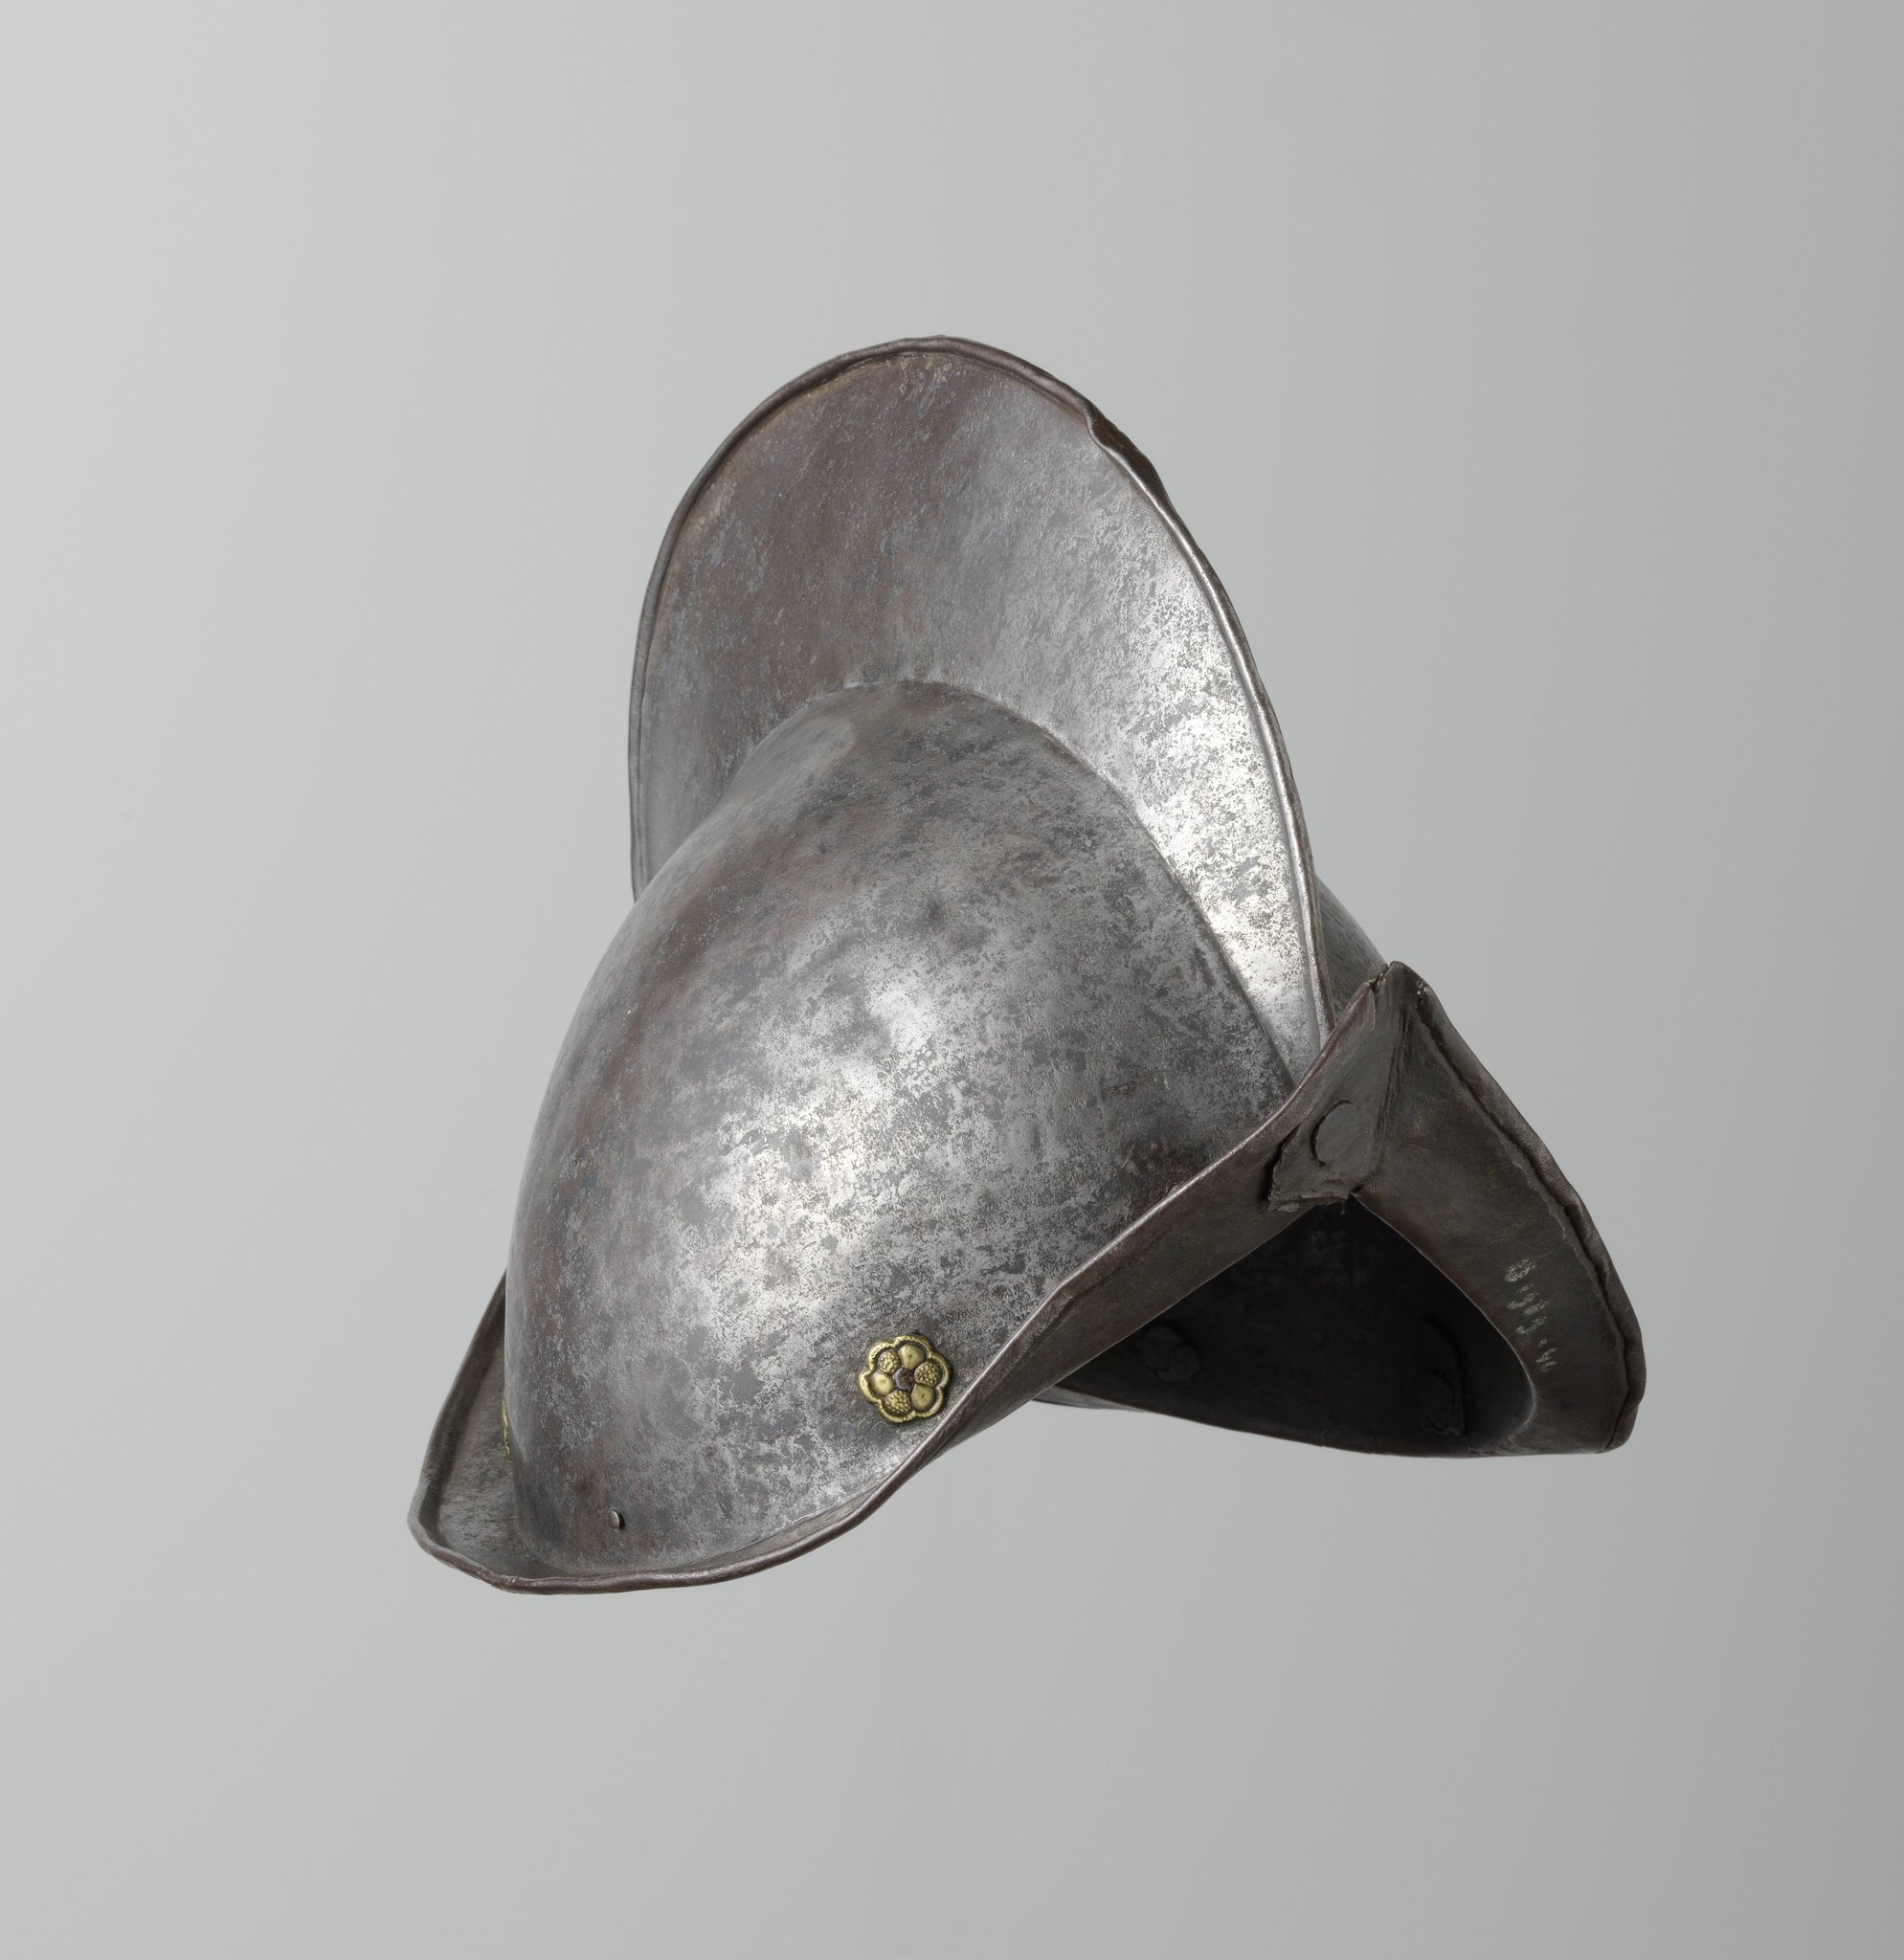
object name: morion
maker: Anonymous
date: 1600-1699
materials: copper, iron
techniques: striking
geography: netherlands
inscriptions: : ‘01989-40’, : ‘4495’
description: Morion, ijzer, blank, van twee platen gemaakt, diepe helmbol met hoge omgeflenste kam en voor en achter opgetrokken kleppen. Rand van de klep is omgeflenst. Rondom de basis van de helmbol rondom zes geelkoperen sierrozetten. Aan beide zijden ontbreken drie sierrozetten. Gezwarte binnenzijde, twee blanke krassen aan weerzijden van de kamgleuf.